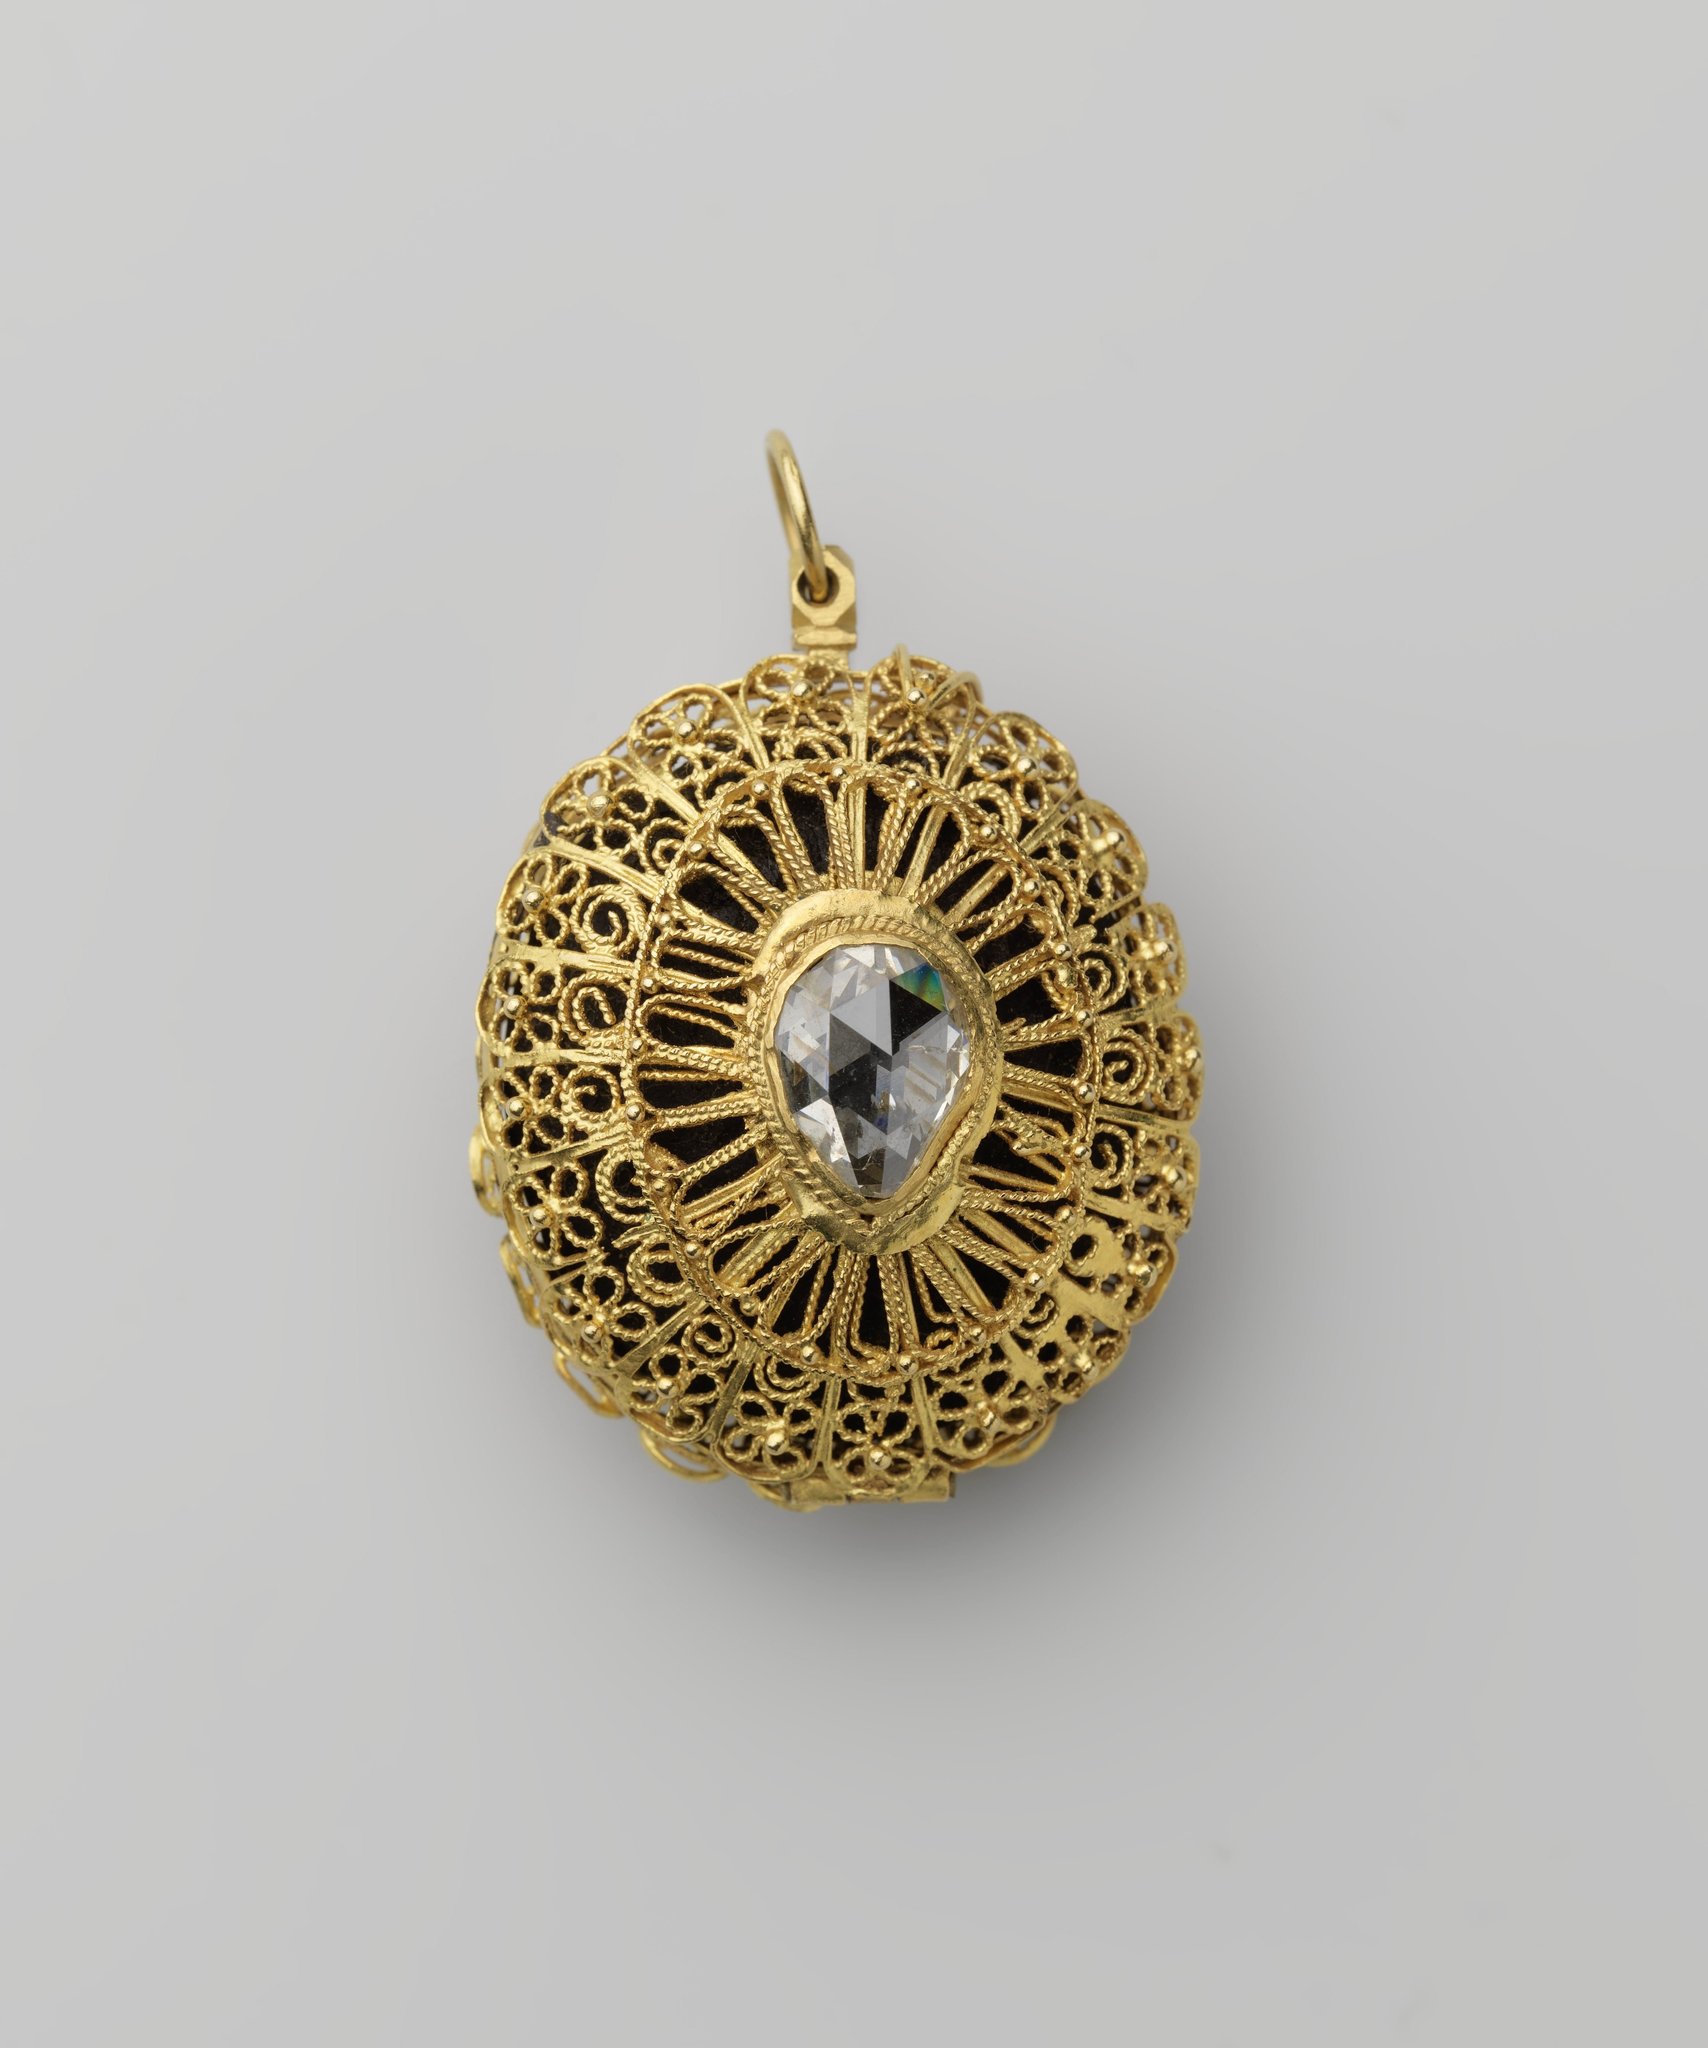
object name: pomander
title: Reukbal van goud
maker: Anonymous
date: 1810-1850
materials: diamond, gold, silk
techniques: filigree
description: Reukbal in zakje. Filigrein met een roos geslepen diamant in peervorm. Met reukbal van mirre, wierook en labdanum. In zak twee stroken kant.